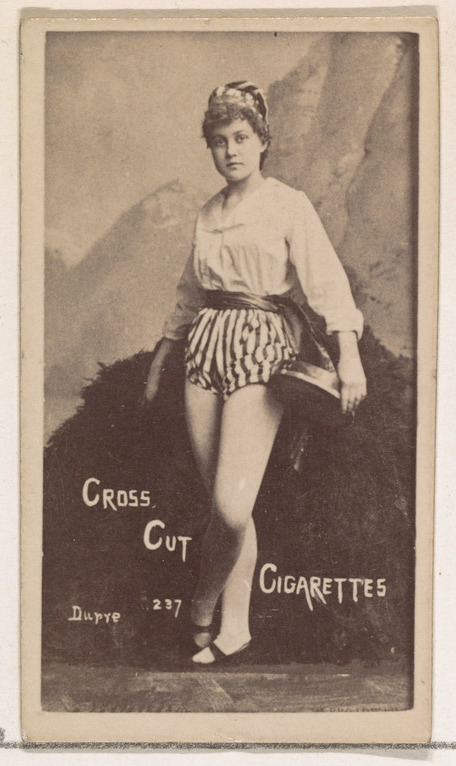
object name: print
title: Card Number 237, Dupre, from the Actors and Actresses series (N145-1) issued by Duke Sons & Co. to promote Cross Cut Cigarettes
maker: w. duke, sons & co.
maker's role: publisher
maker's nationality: american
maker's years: 1870-1920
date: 1880-1889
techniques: albumen silver print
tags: portraits,women,actresses